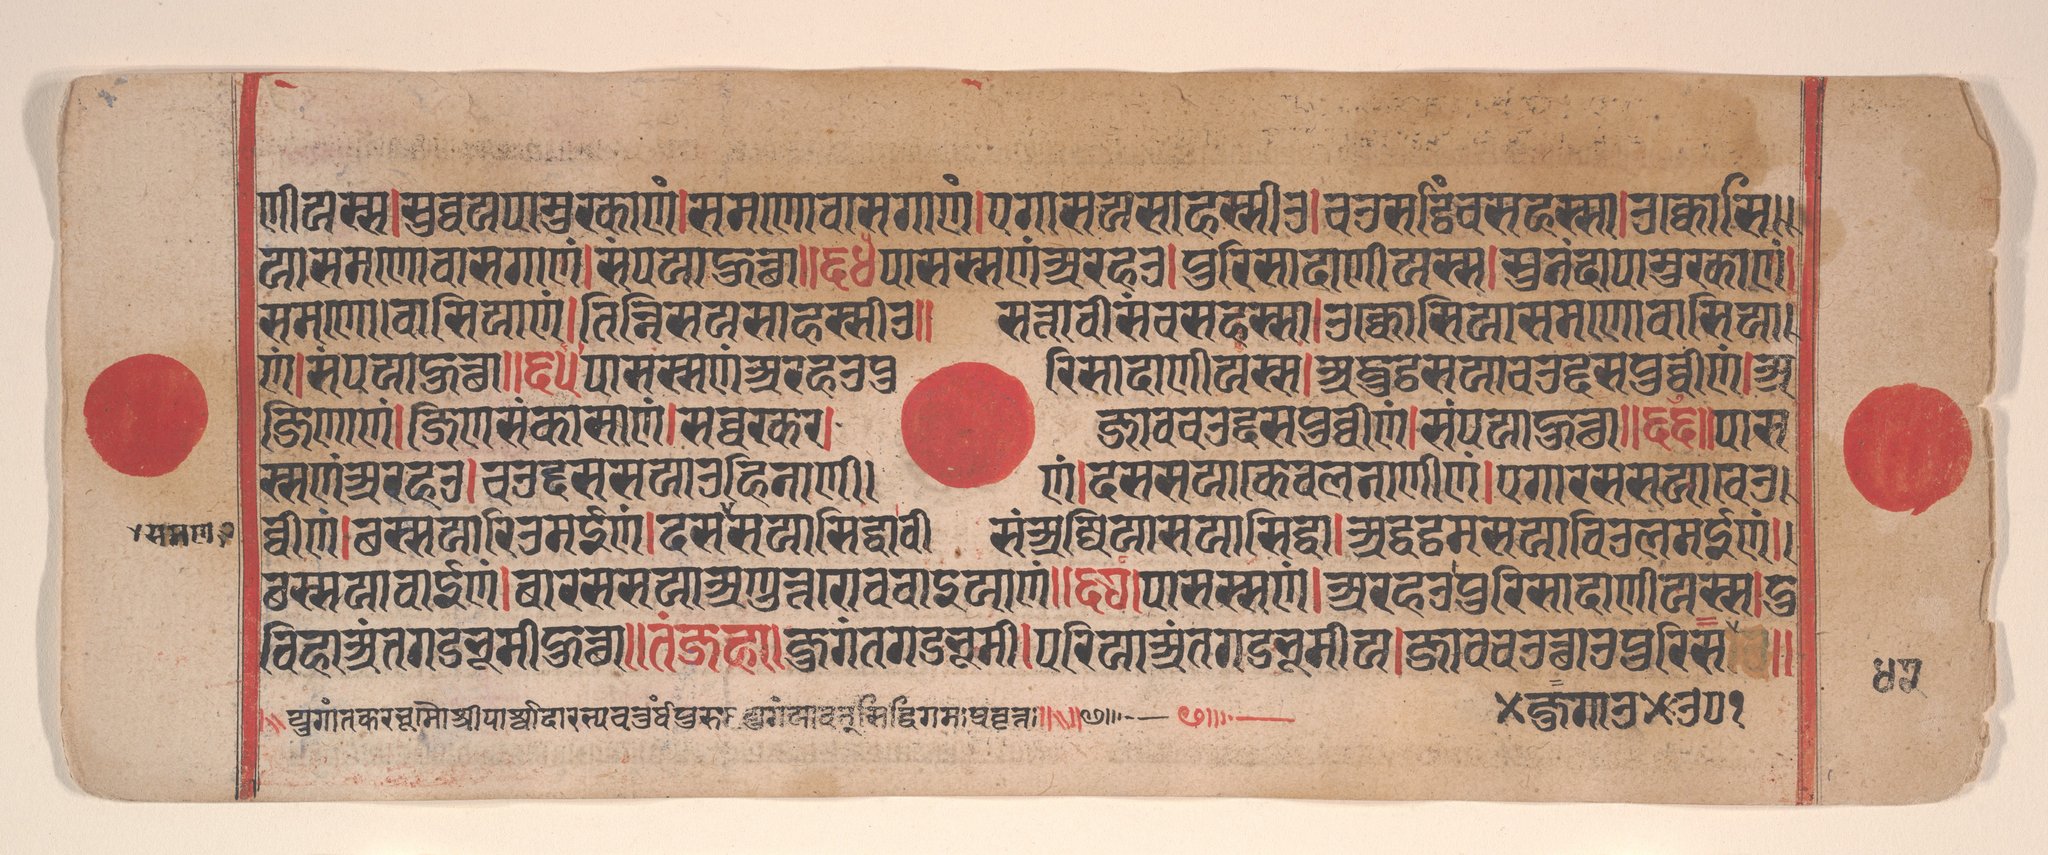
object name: folio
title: Leaf from a Kalpa Sutra (Jain Book of Rituals)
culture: indian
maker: bhadrabahu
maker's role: artist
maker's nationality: indian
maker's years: 356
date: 1401-1500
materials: gold, ink, paper, watercolor